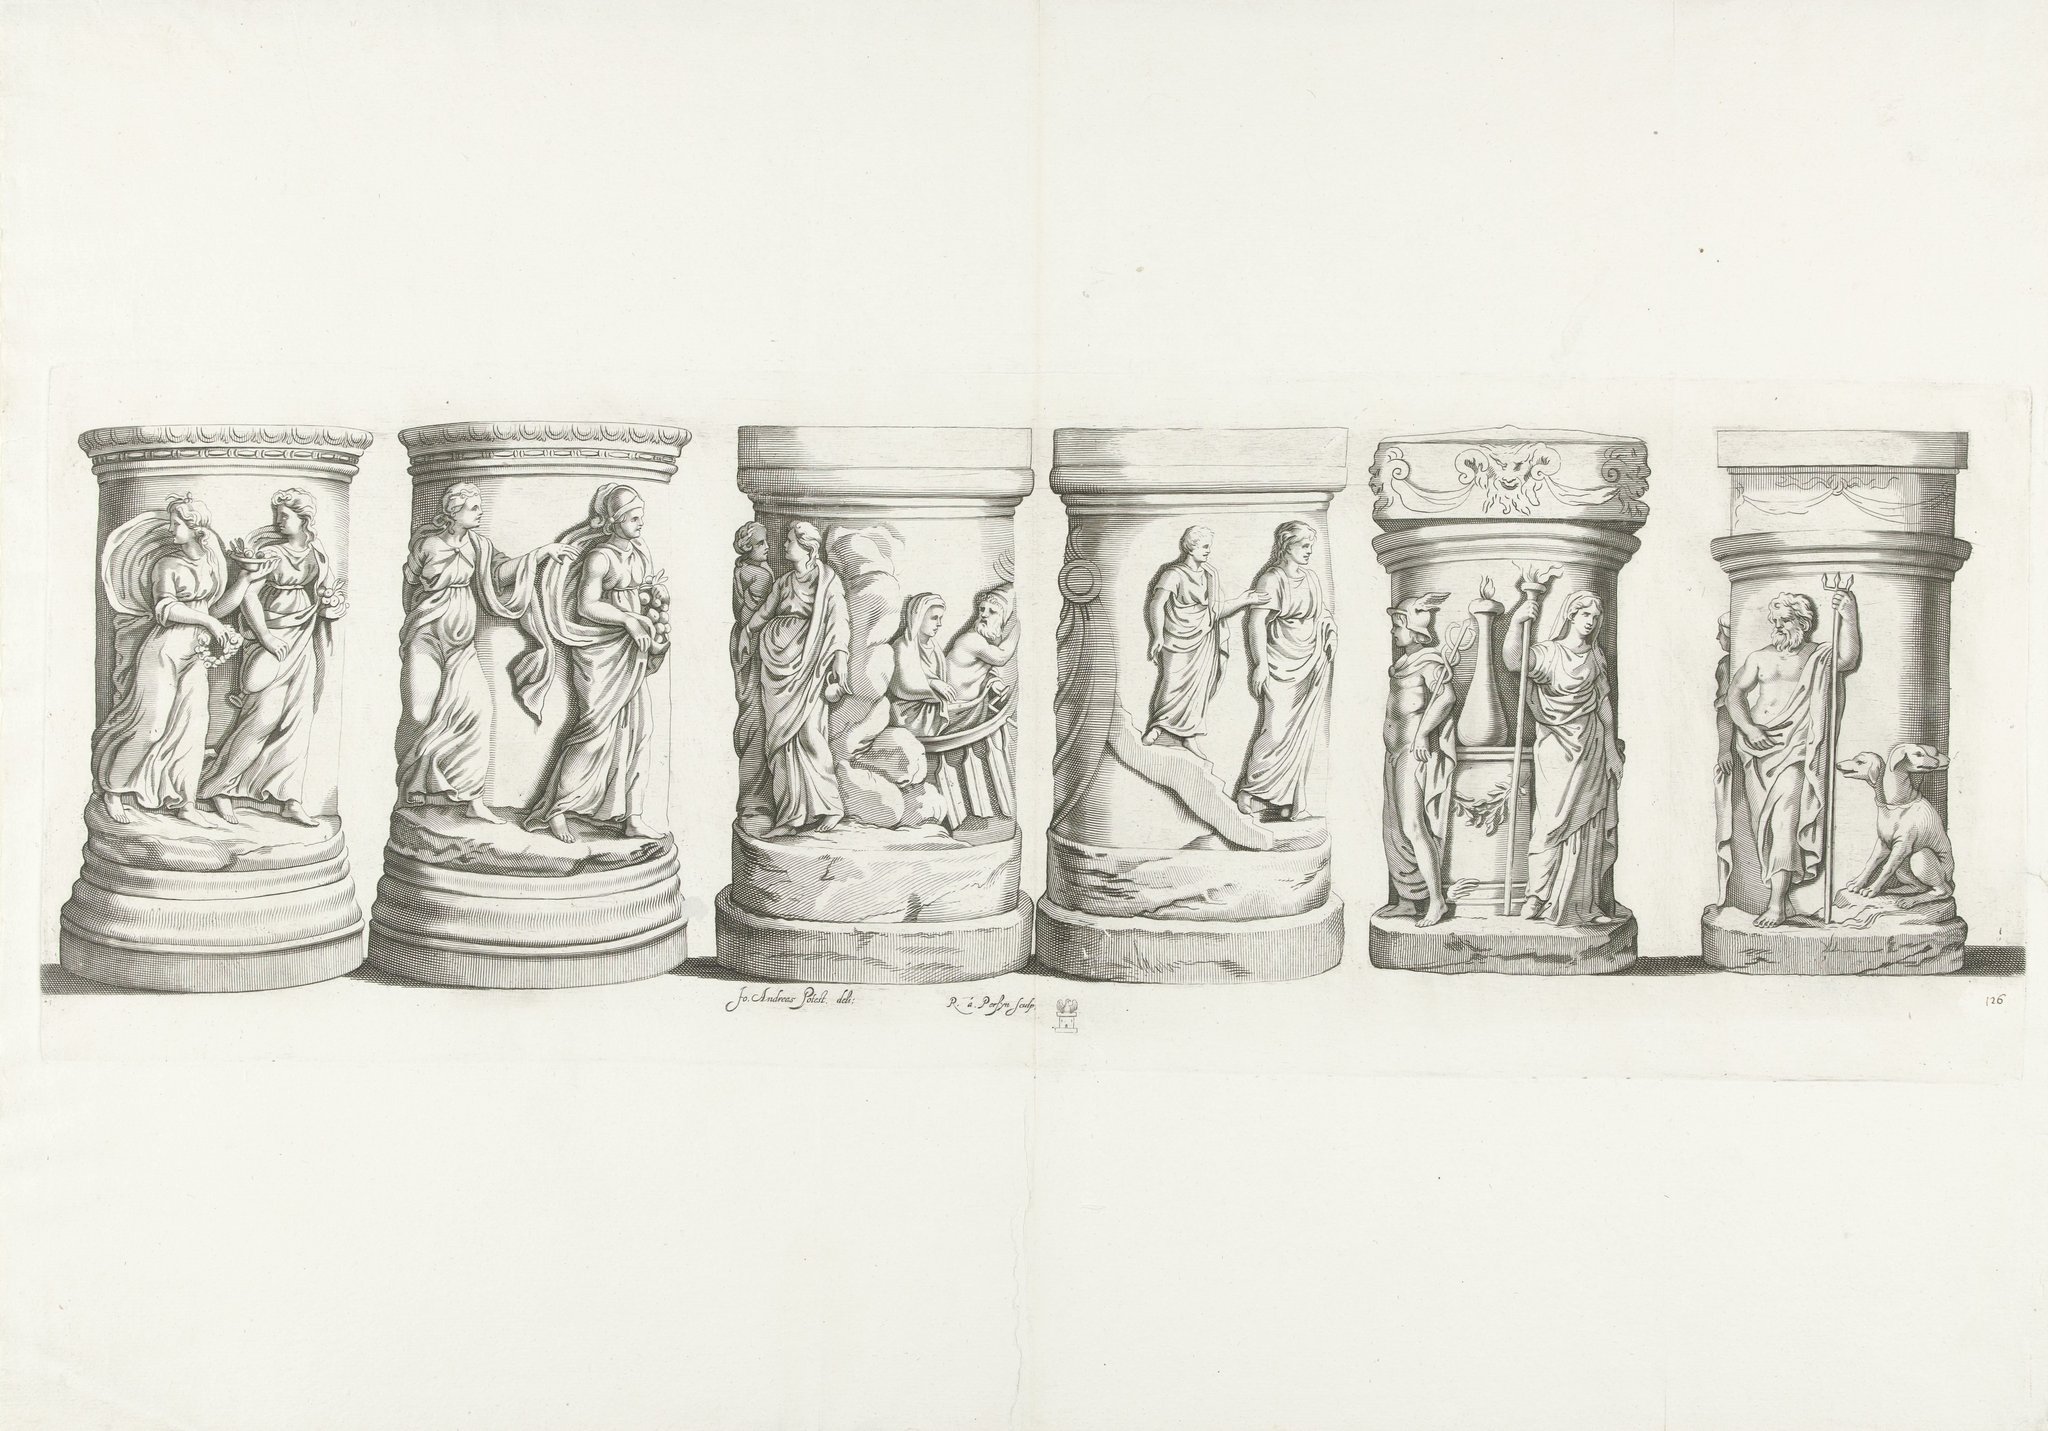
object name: print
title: Zuilen waarop de geschiedenis van Pluto en Proserpina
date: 1640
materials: paper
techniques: engraving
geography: rome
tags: rome, vincenzo giustiniani (1564-1637), (story of) proserpina (persephone, core), libera, column, pillar ~ architecture, (story of) pluto (hades), dis pater, orcus, piece of sculpture, reproduction of a piece of sculpture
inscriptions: number: ‘126’, collector's mark: Lugt 2228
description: Romeinse zuilen waarop de geschiedenis van Pluto en Proserpina. Midden onder het wapenschild van Vincenzo Giustiniani. Prent uit een publicatie met reproductieprenten naar de sculpturen in de verzameling in de Galleria Giustiniani te Rome.